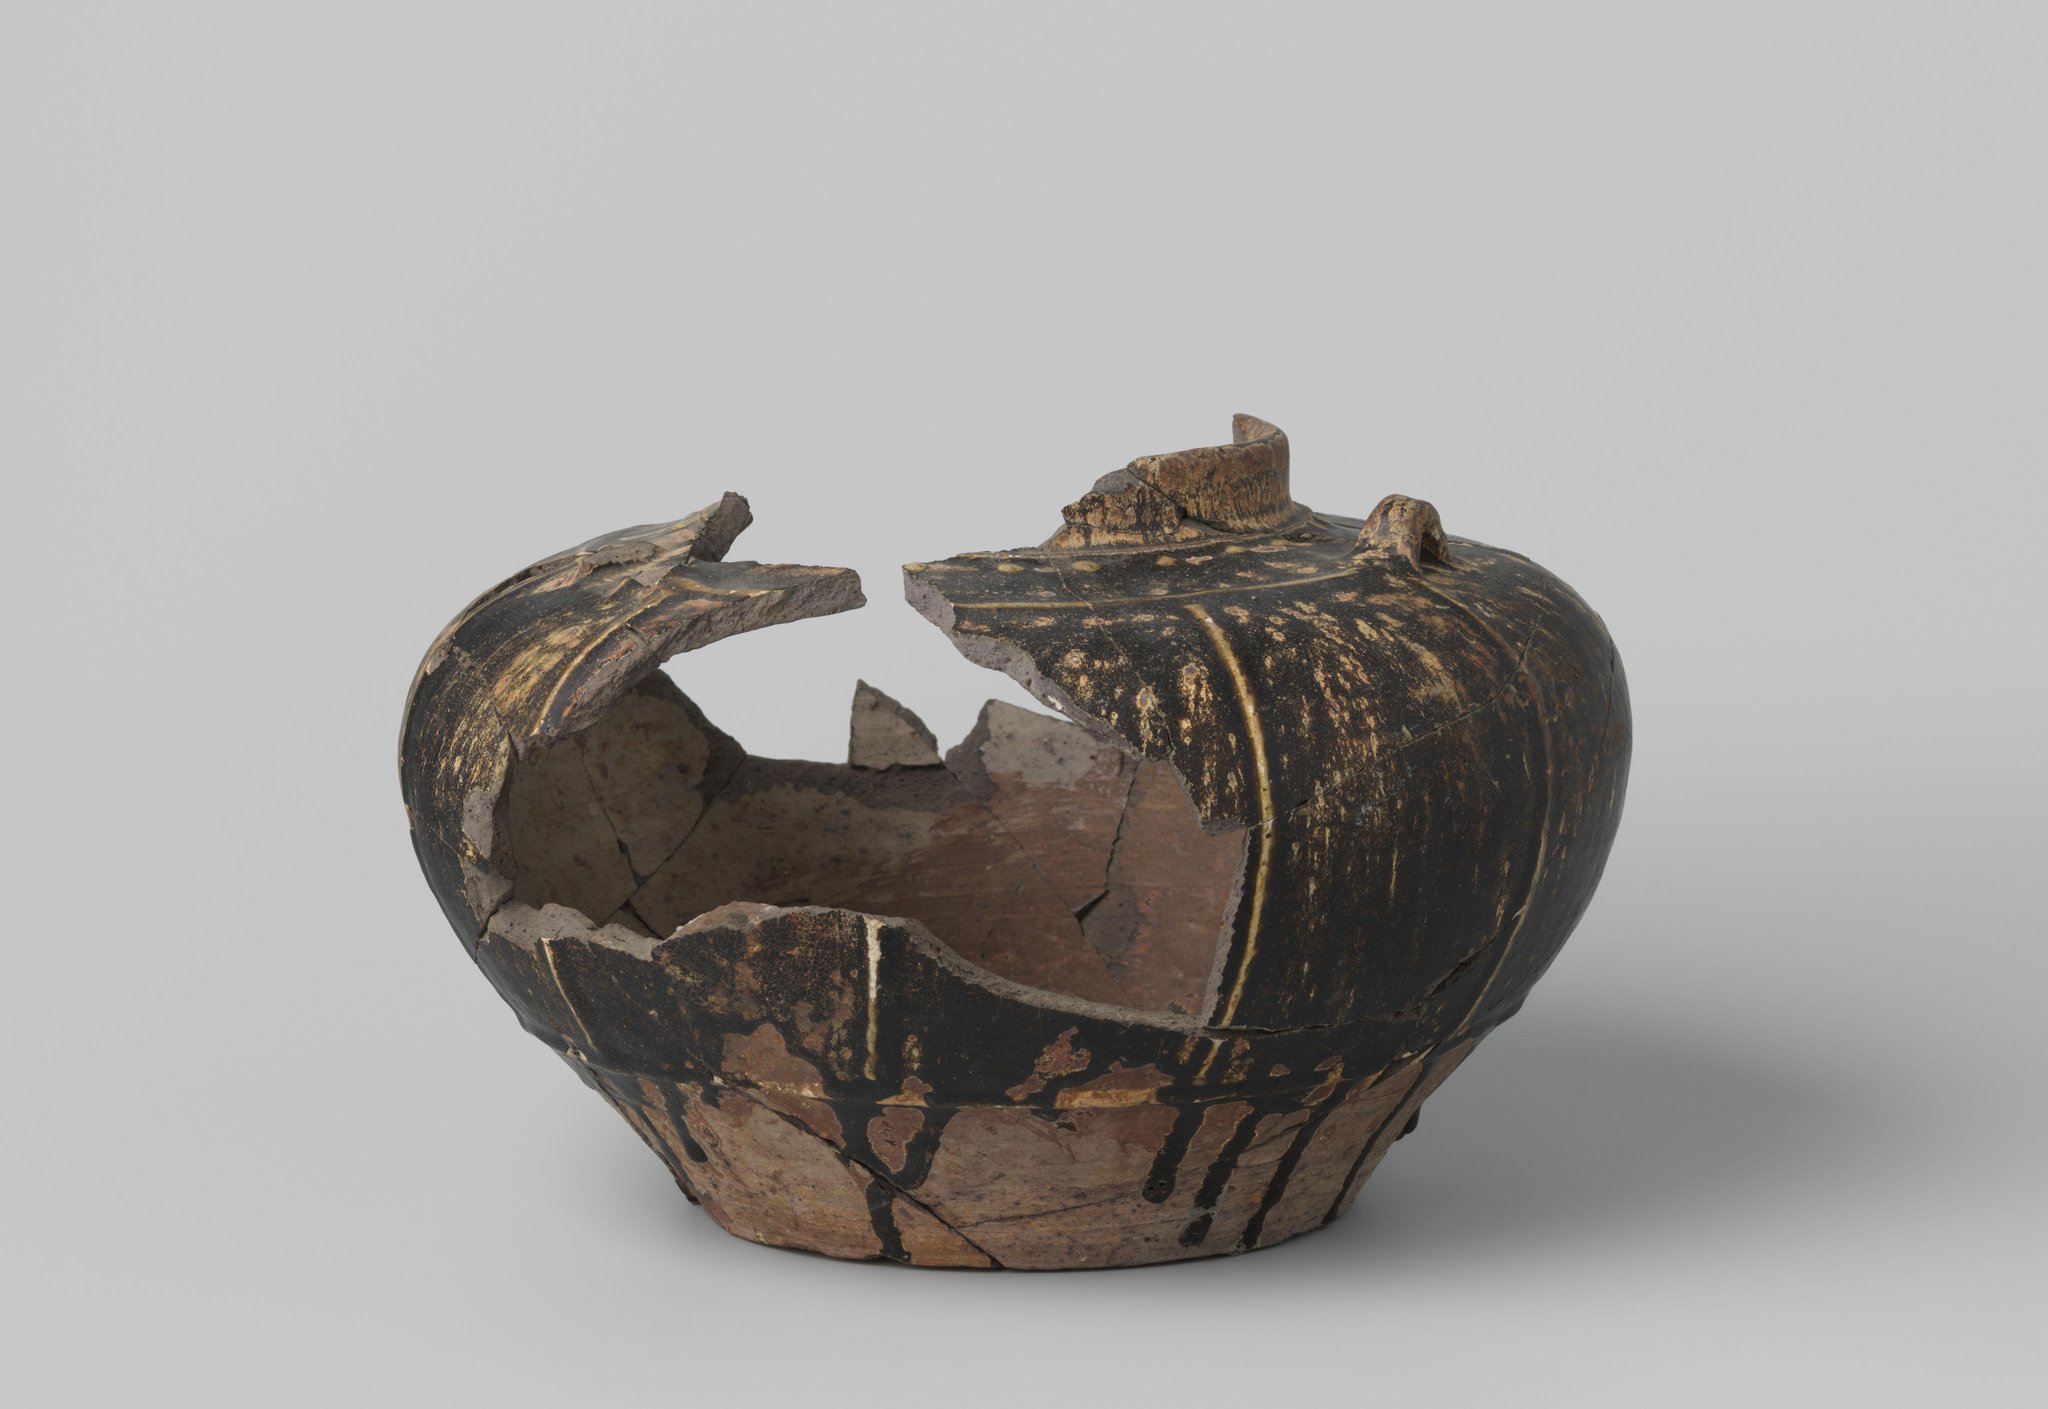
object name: martavaan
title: Martavaan uit V.O.C.-schip de 'Witte Leeuw'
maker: Anonymous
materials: porcelain, stoneware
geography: martaban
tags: verenigde oostindische compagnie, sint-helena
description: A jar. The decoration consists of a ridge between shoulder and neck with underneath a dotted line made of yellow slip. There is another slip-band at the height of the ears from where ten vertical bands run down. These end on a second horizontal band around the lower part of the body.